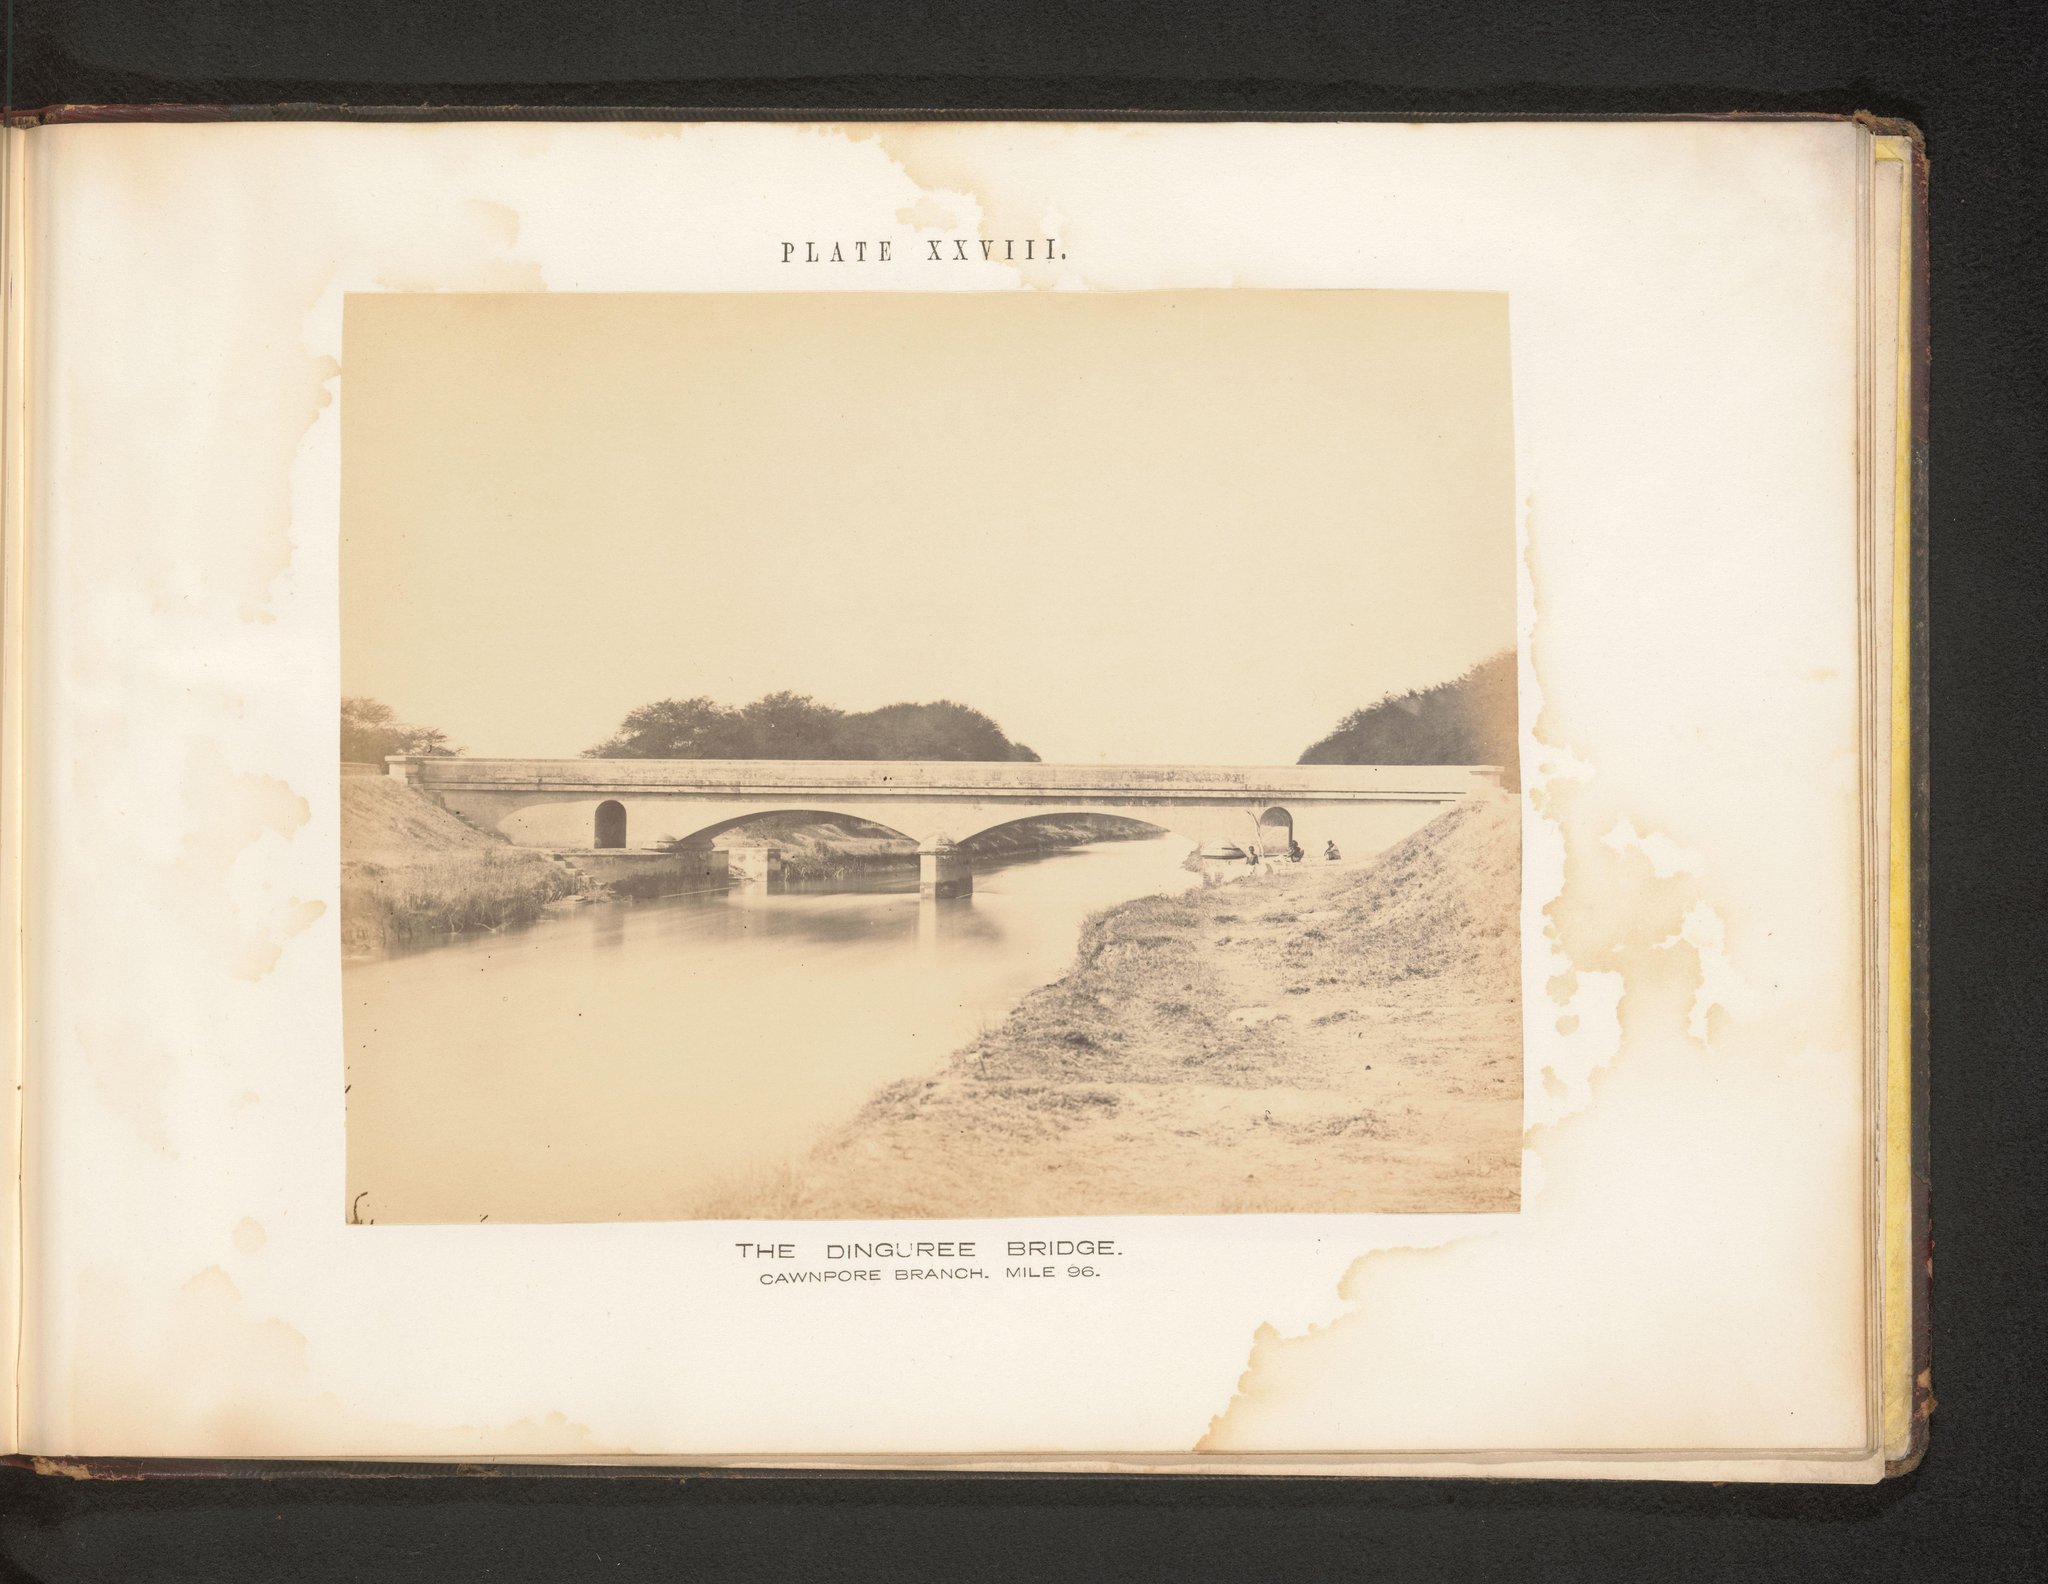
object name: photograph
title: The Dinguree bridge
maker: thomas george glover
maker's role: fotograaf, luitenant-kolonel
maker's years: 1825-1881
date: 1862-1867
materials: photographic support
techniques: albumen print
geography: india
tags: river, bridge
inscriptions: inscription: ‘Plate XXVIII’, inscription: ‘Cawnpore branch. mile 96.’